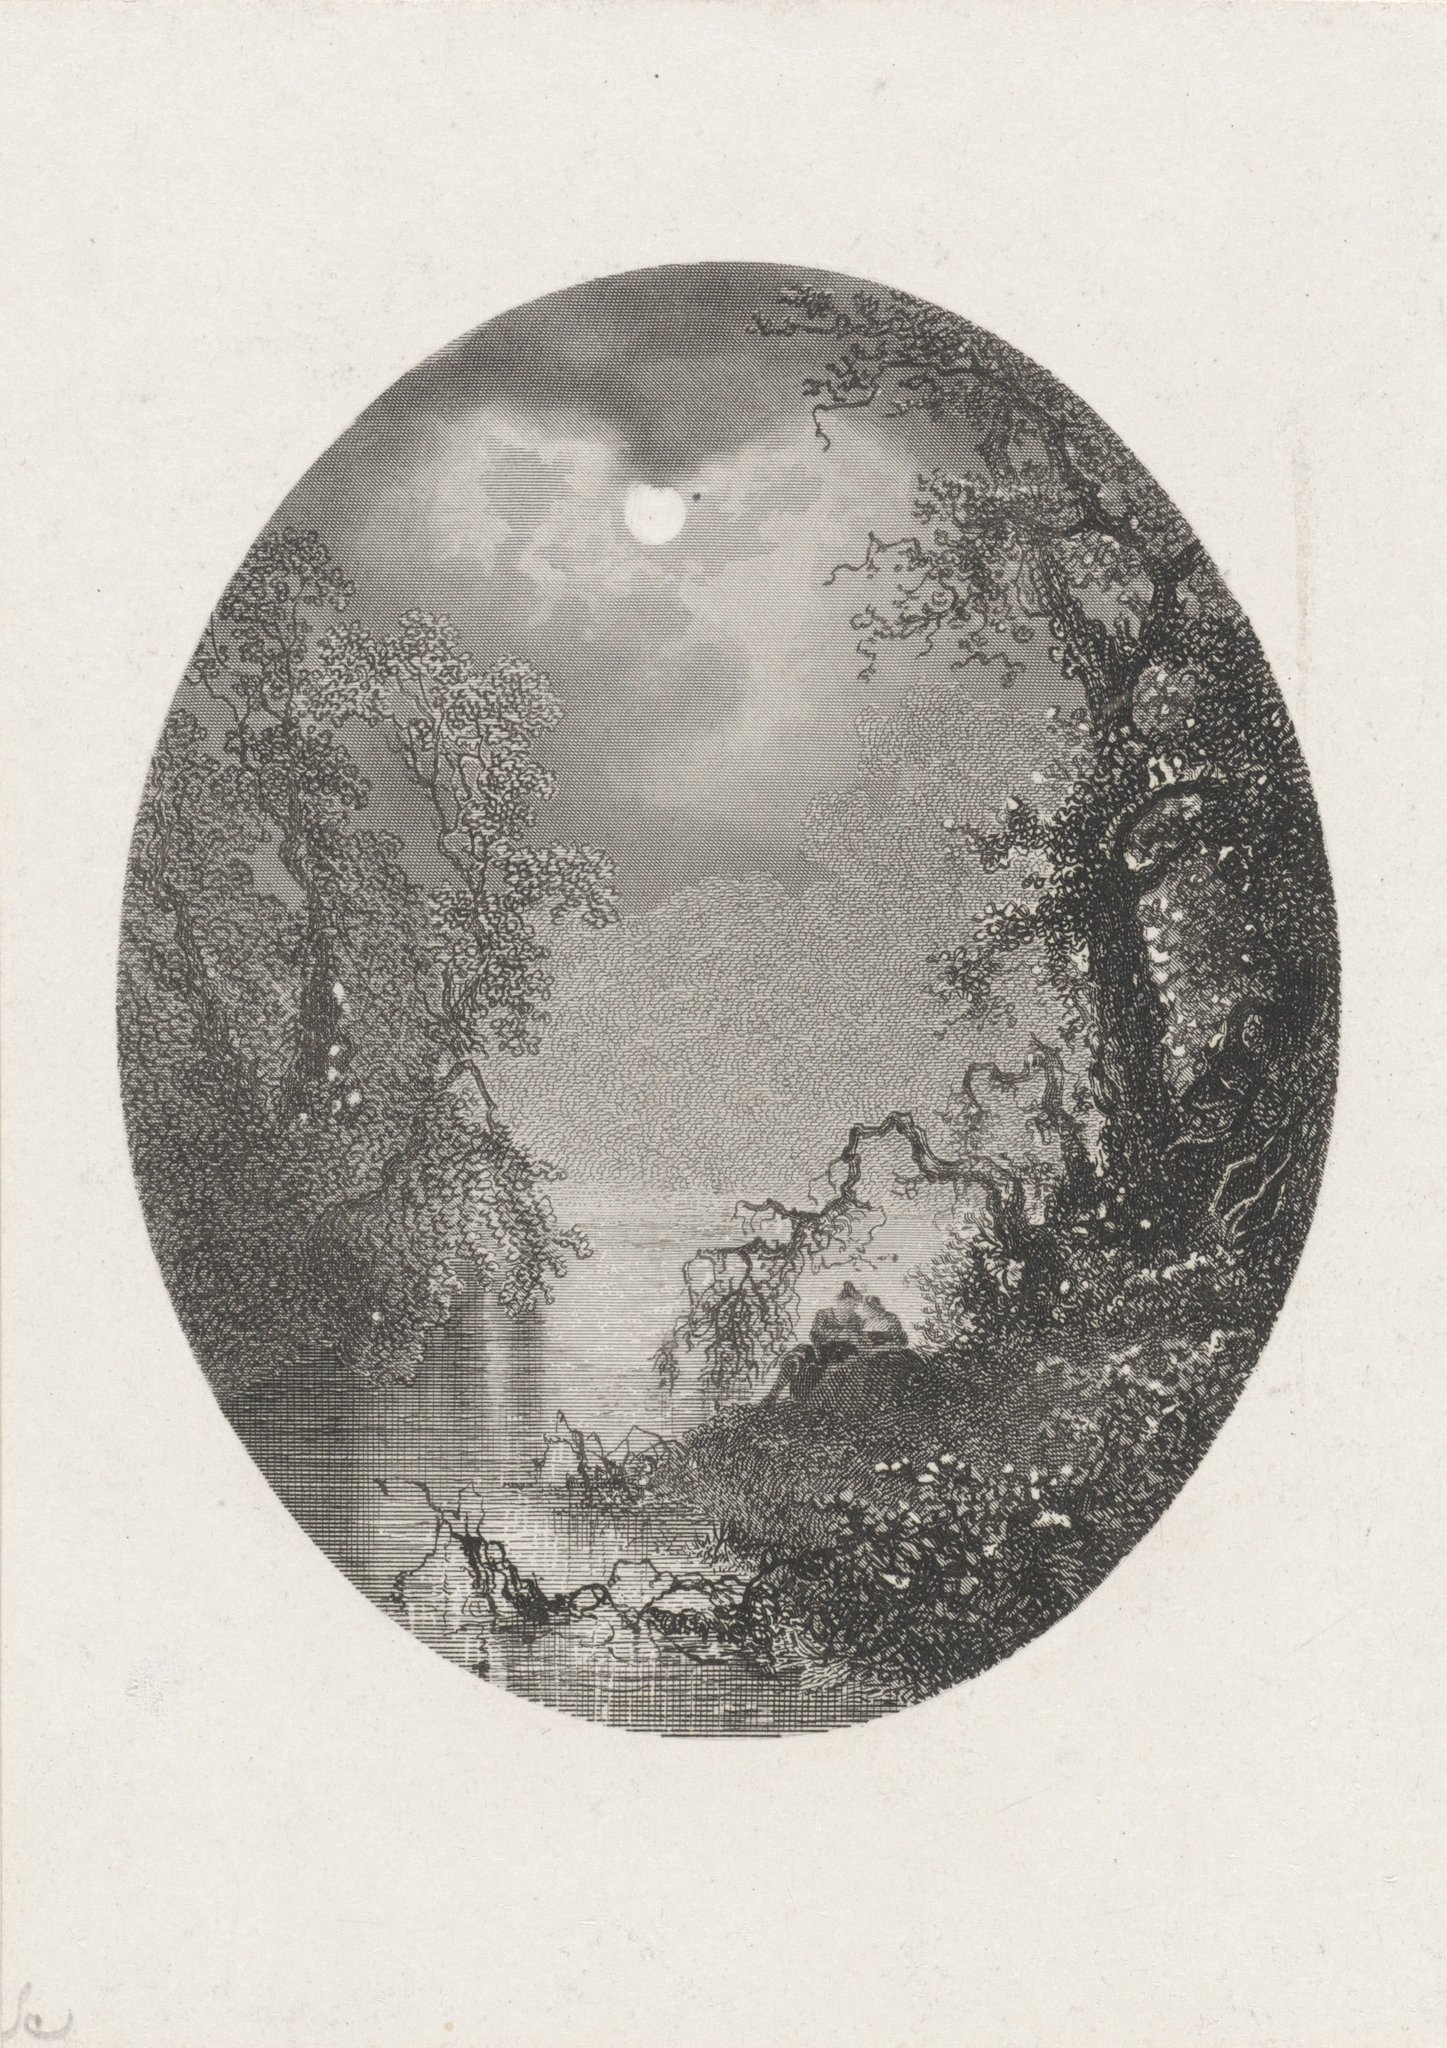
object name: print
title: Landschap bij nacht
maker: dirk jurriaan sluyter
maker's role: draughtsman, print maker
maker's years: 1811-1886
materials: paper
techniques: engraving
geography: amsterdam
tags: night ~ landscape (sometimes titled 'nox'), couple of lovers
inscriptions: collector's mark: Lugt 2228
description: Een volle maan beschijnt een rivier waarlangs hoge bomen staan. Op de oever zitten een man en een vrouw die elkaar bij de hand houden.